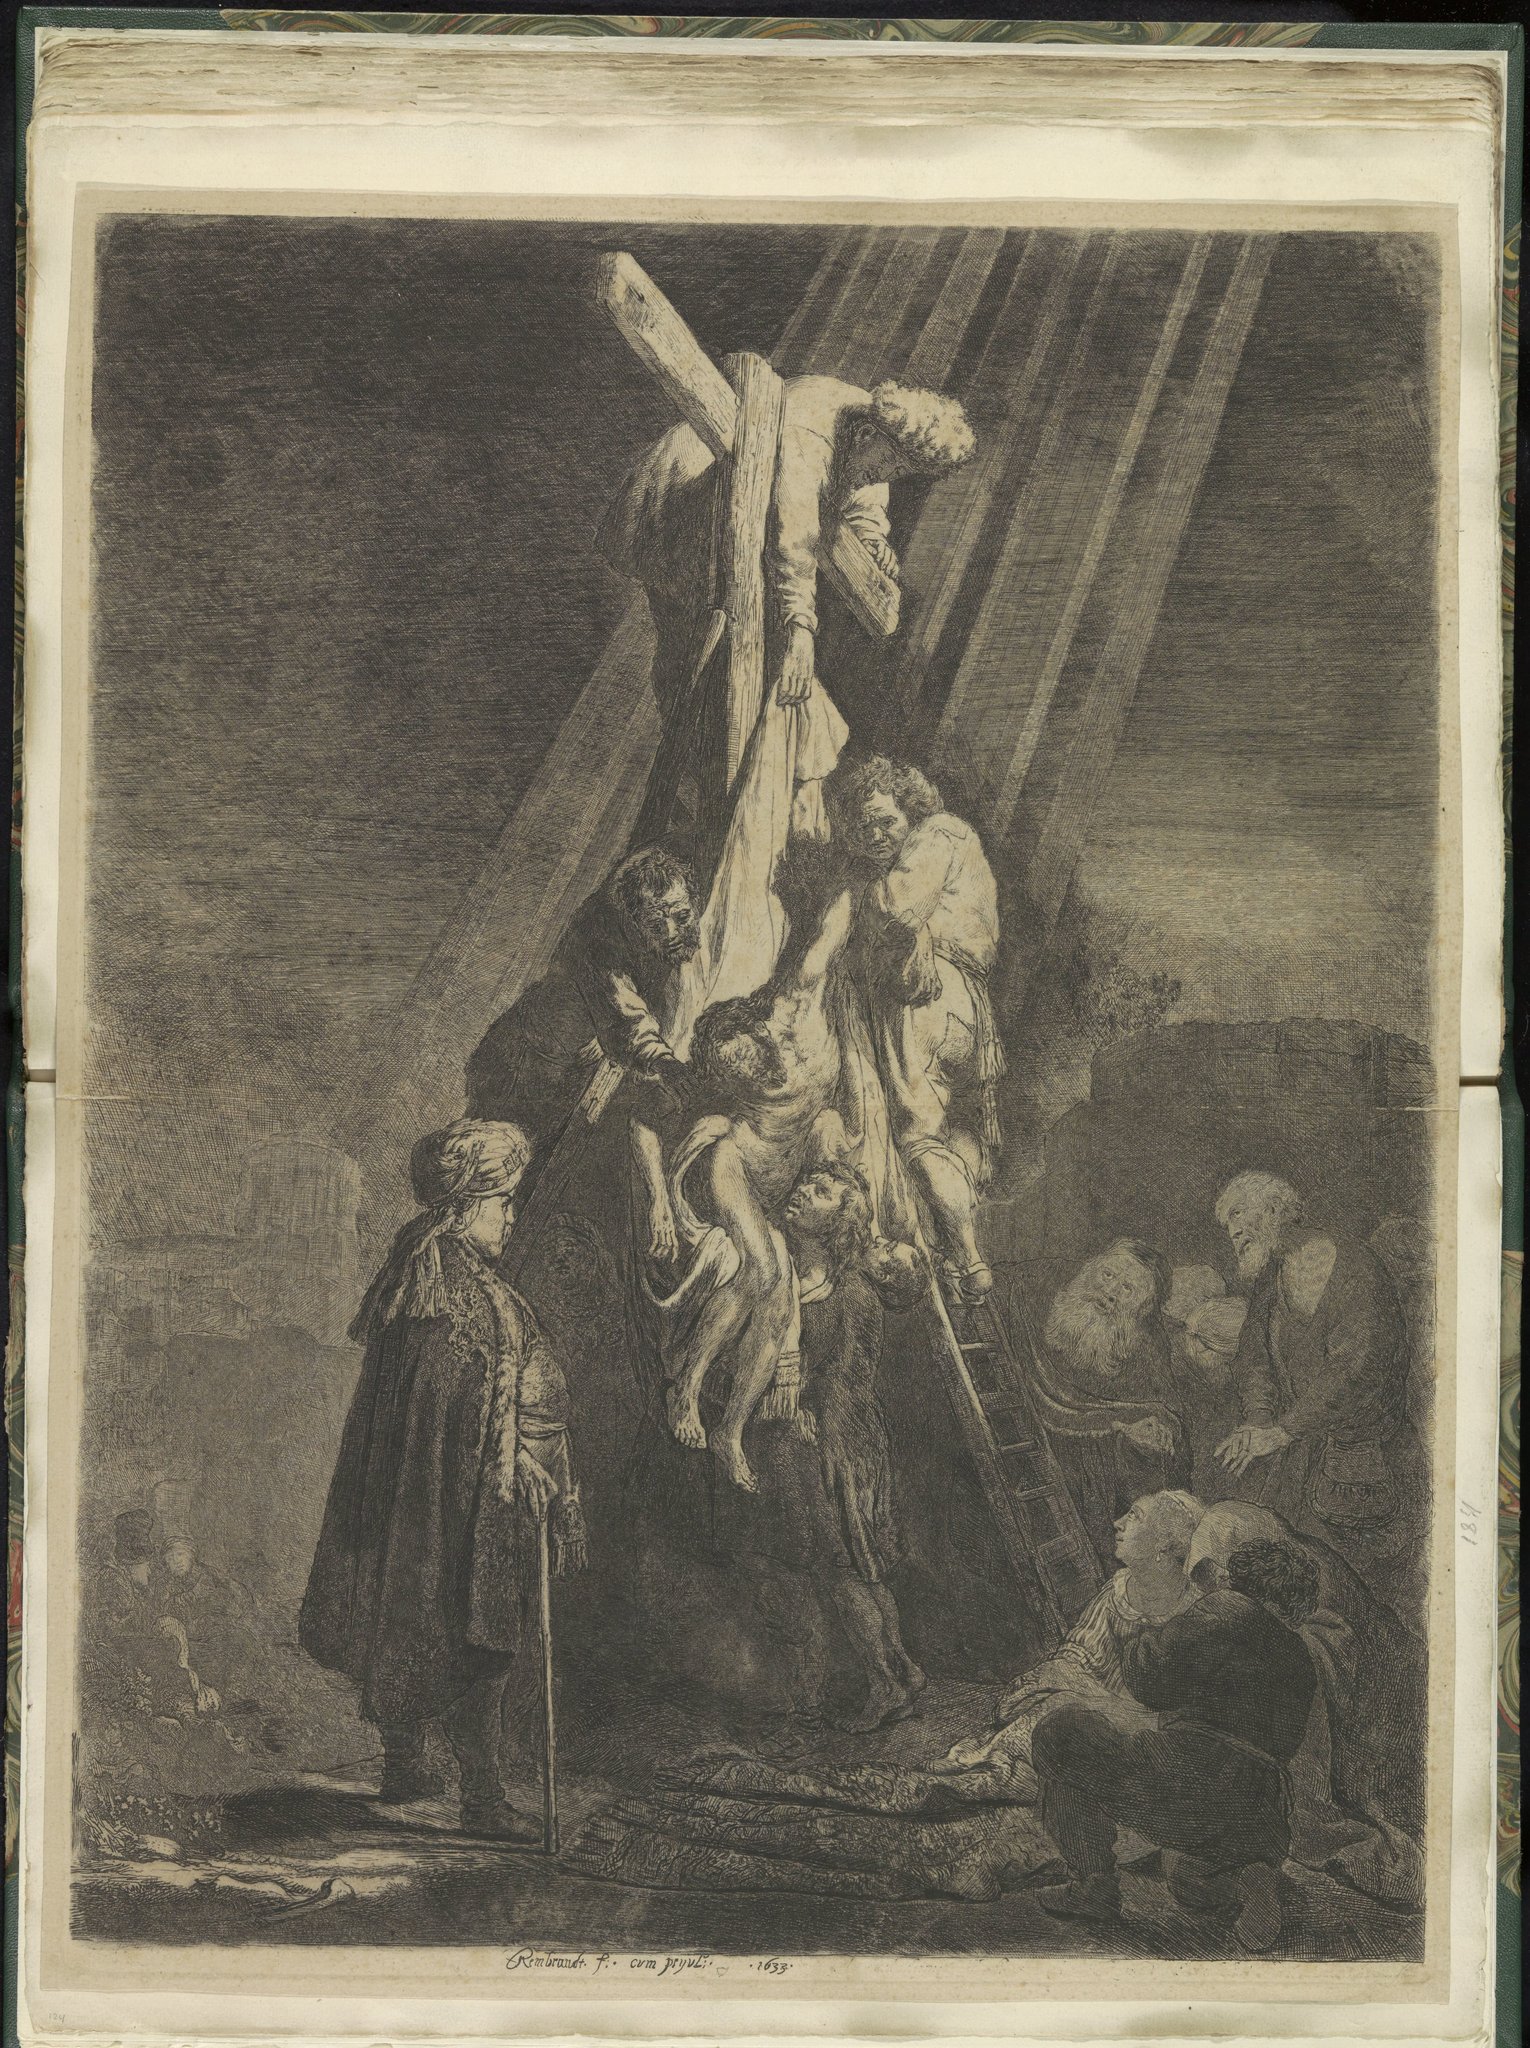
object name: print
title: Recueil de quatre-vingt-cinq estampes originales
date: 1633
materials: paper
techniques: engraving, etching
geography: paris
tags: descent from the cross: christ is taken down from the cross, usually by nicodemus and joseph of arimathaea who are standing on the ladders (both arms of christ detached)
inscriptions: date